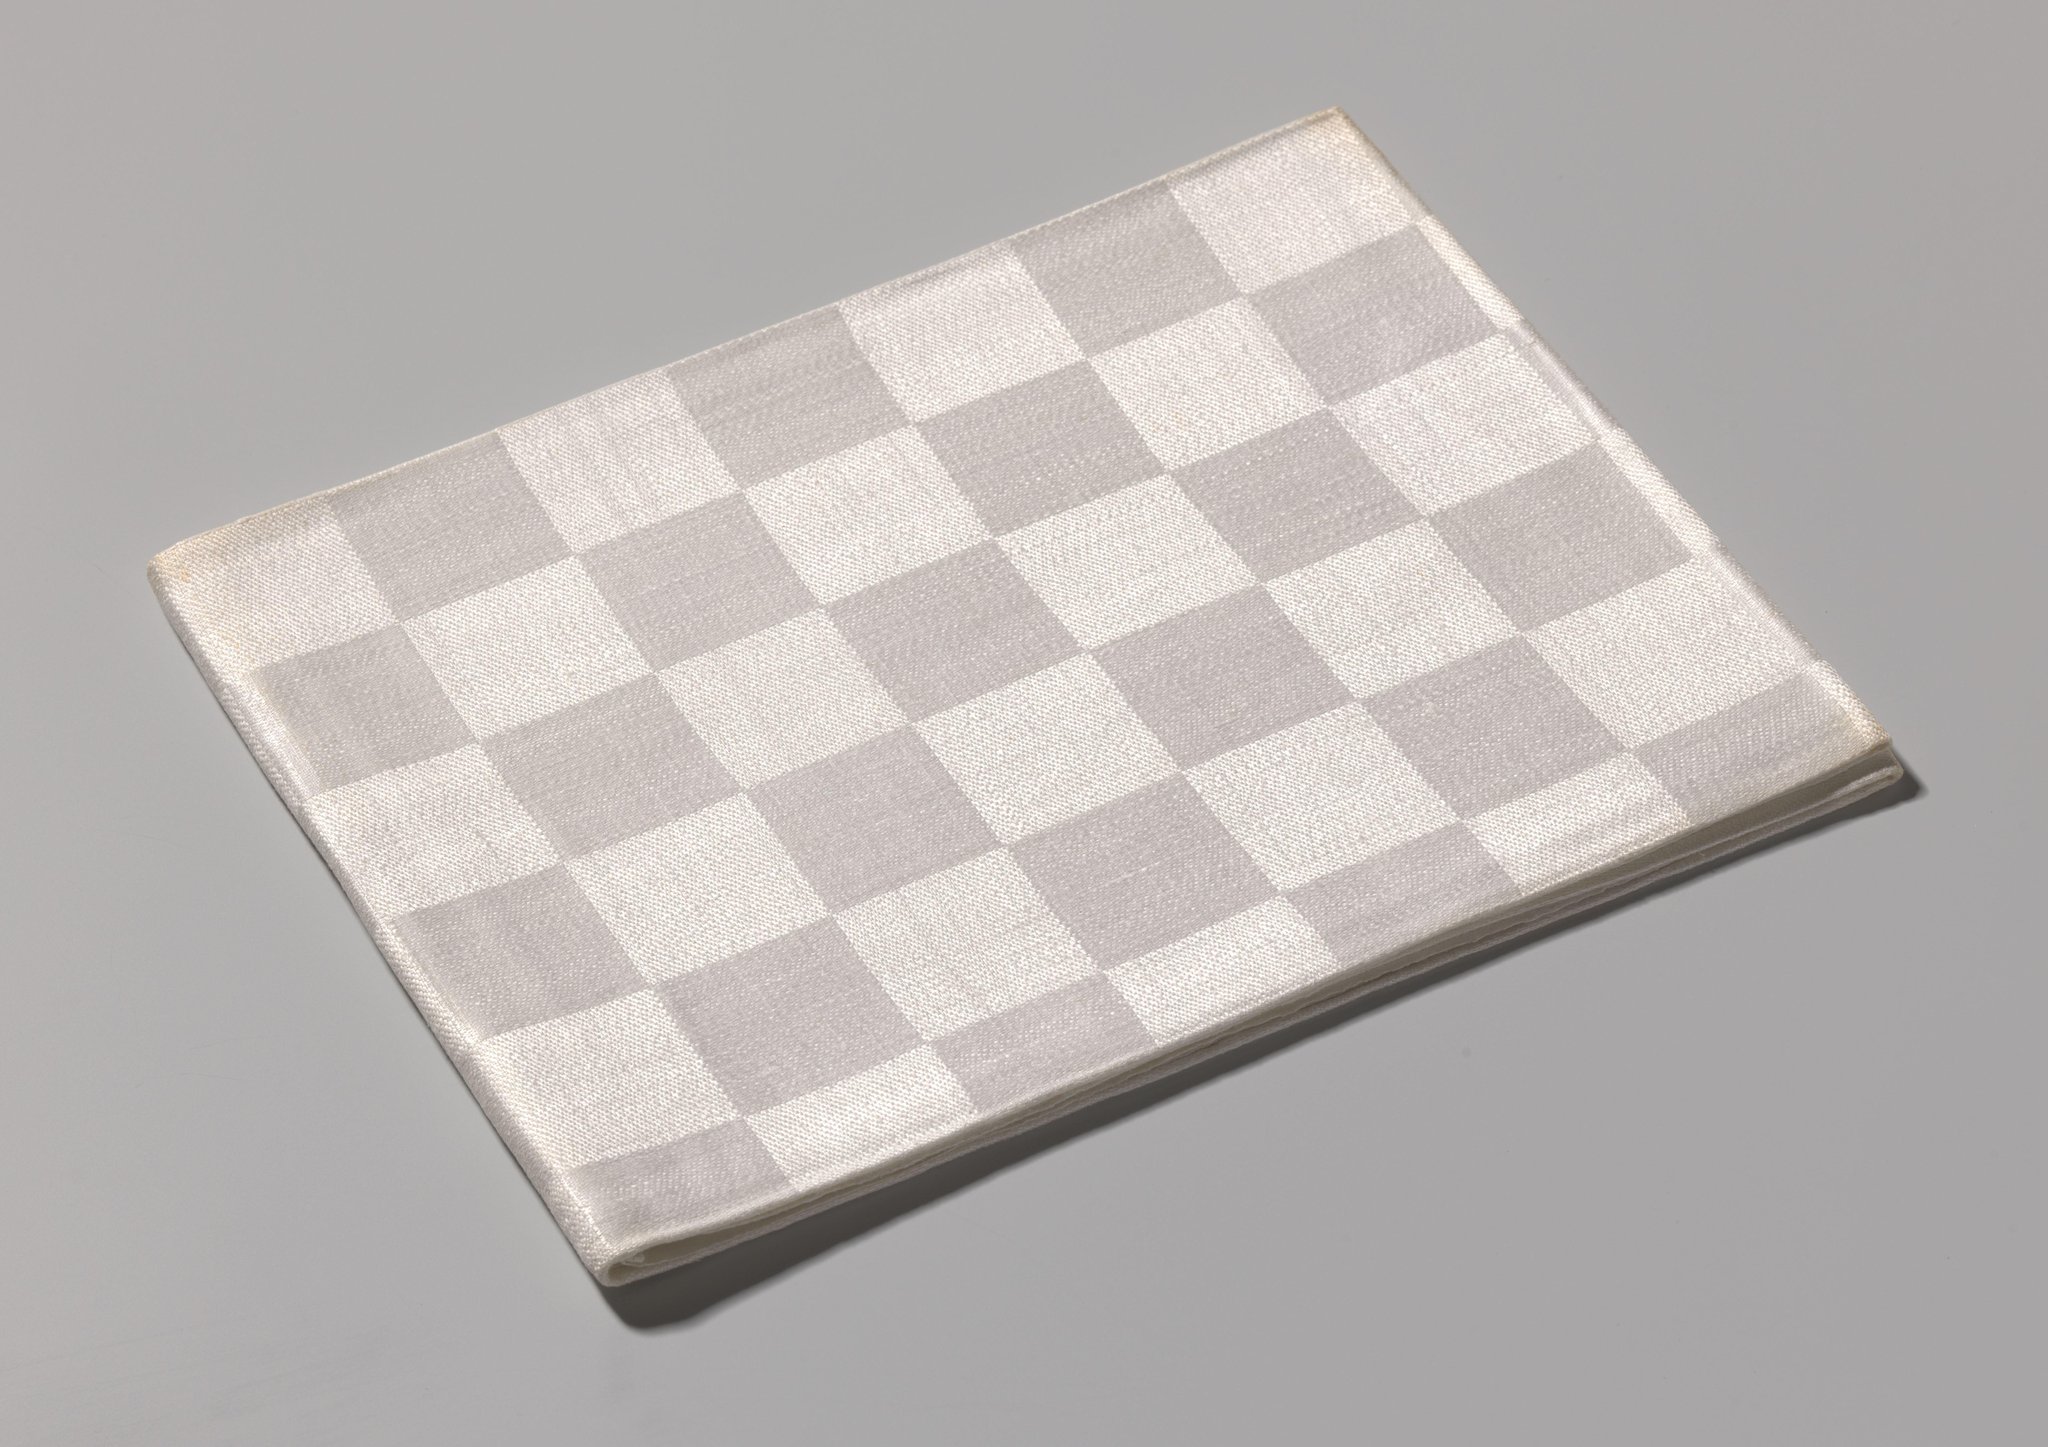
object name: napkin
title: Servet van linnen met pellenpatroon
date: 1830-1870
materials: linen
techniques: peeled fabric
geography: northern netherlands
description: Wit linnen servet met pellenpatroon, merk HW 80.